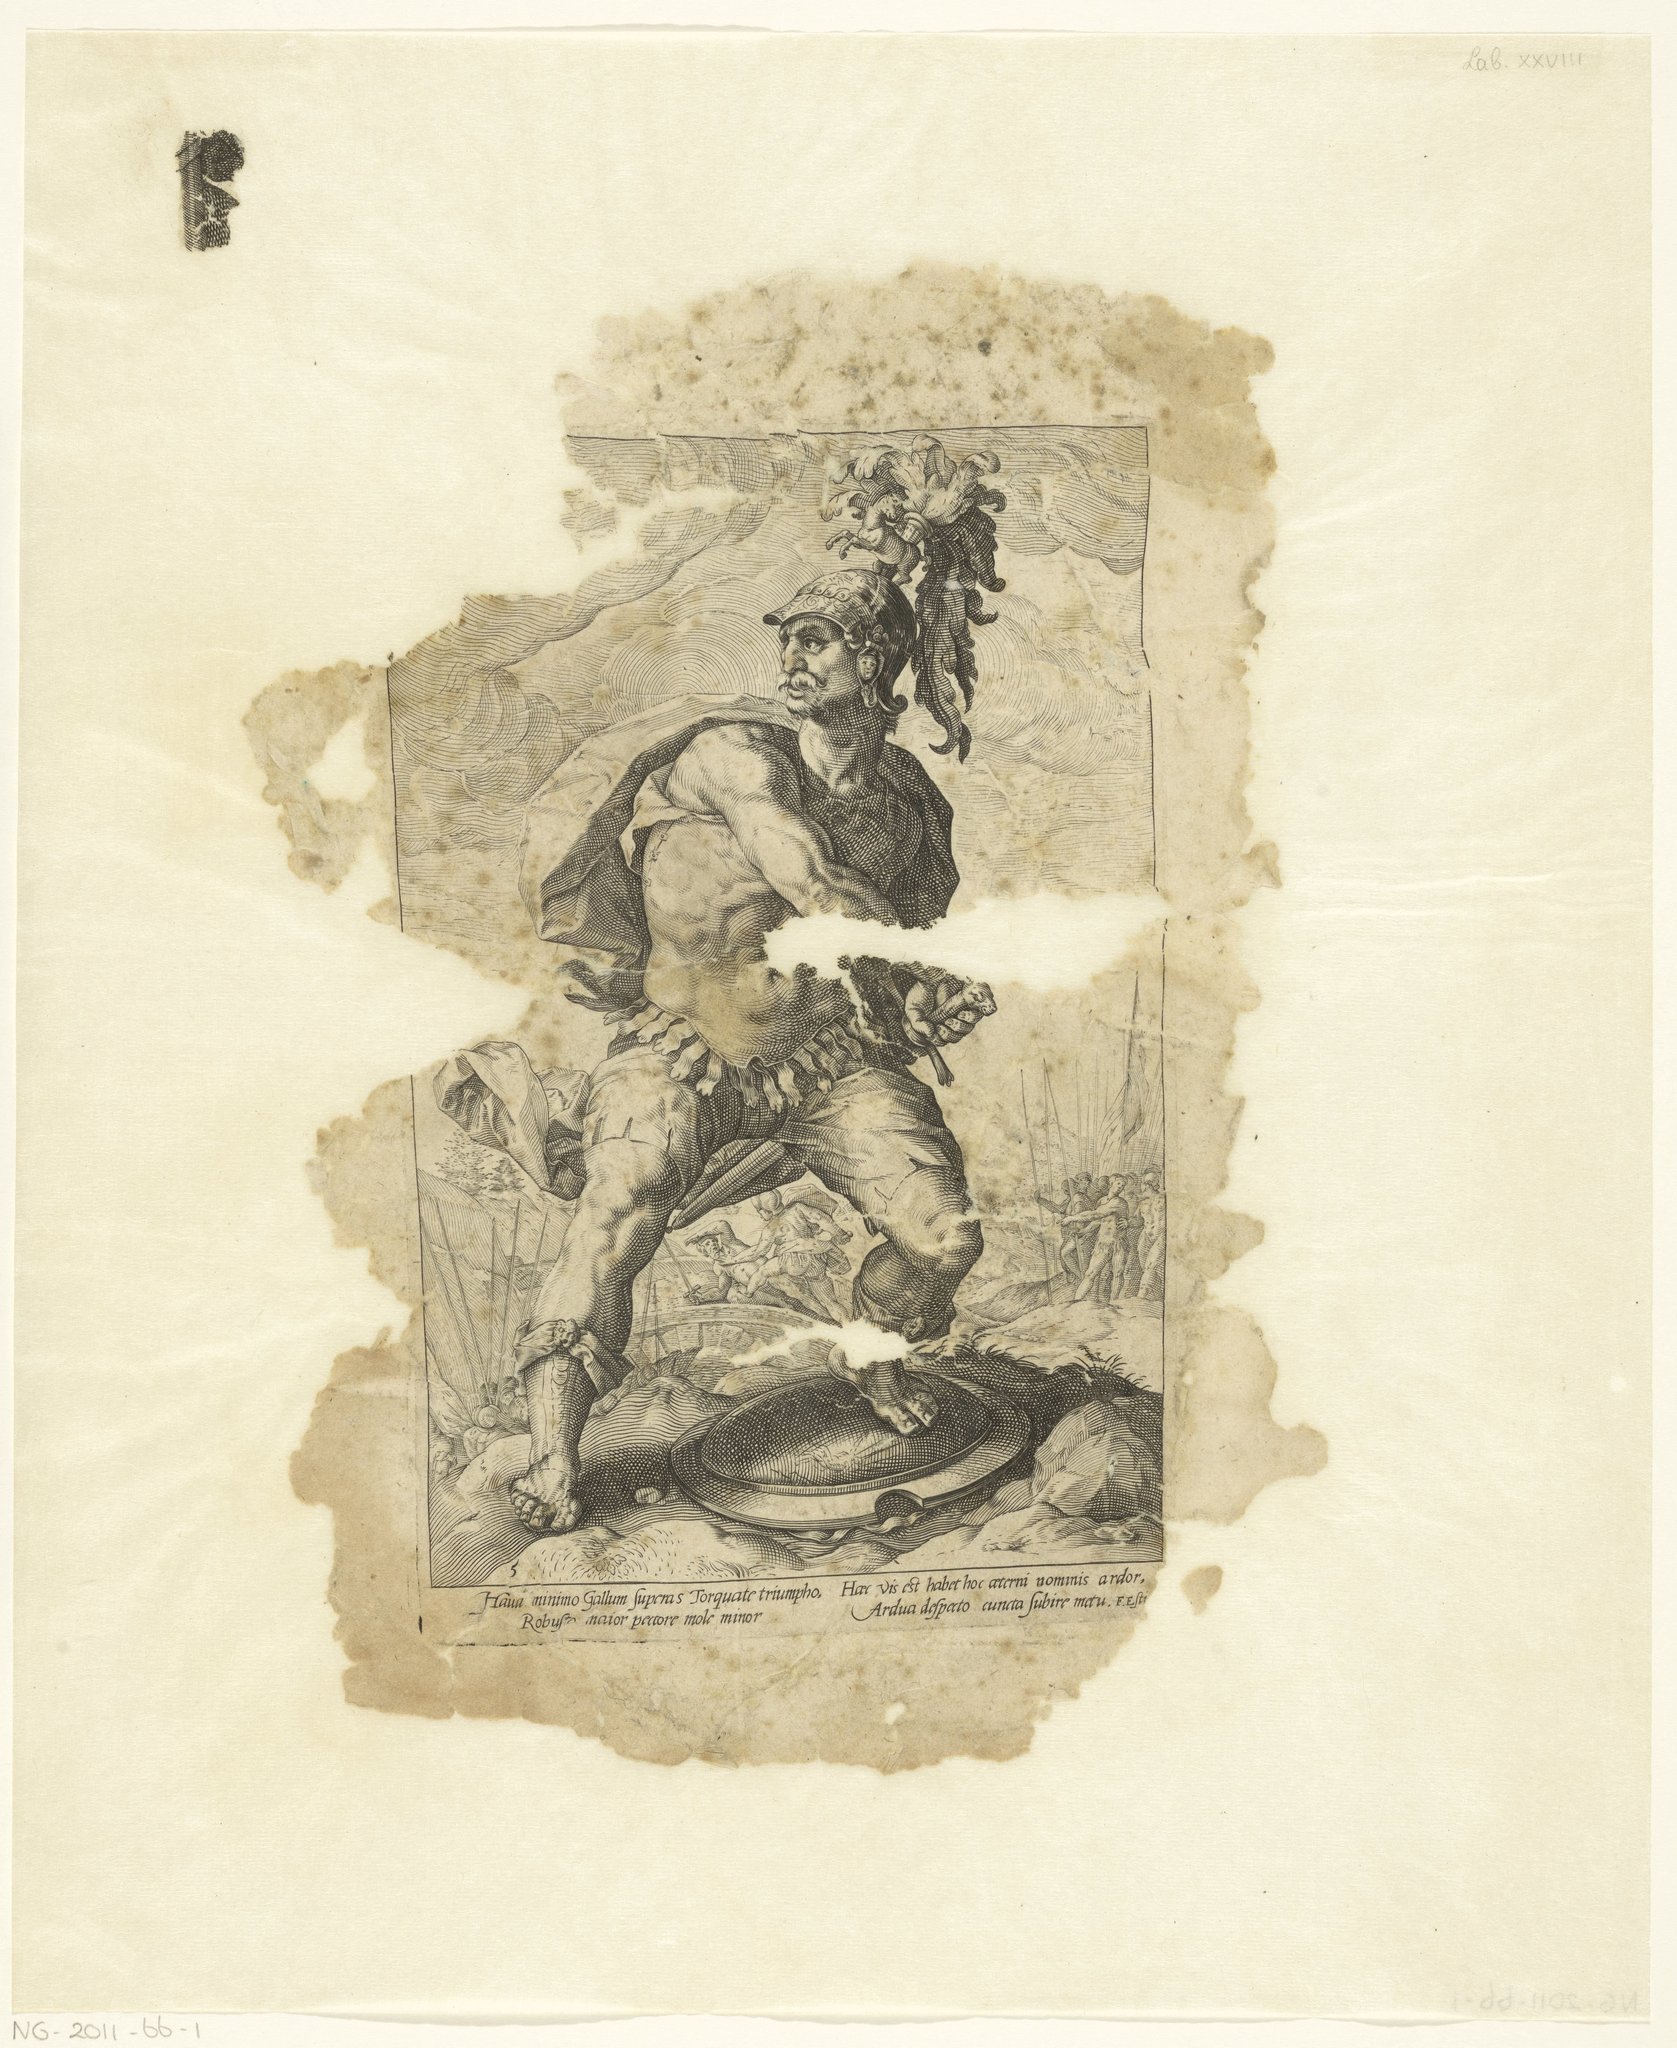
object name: print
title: Romeinse helden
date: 1586-1596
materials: paper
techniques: engraving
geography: northern netherlands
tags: titus manlius torquatus defeats in single combat a gigantic gaul and takes from him his golden neck-chain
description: Deze prent is onderdeel van een serie van tien prenten, bestaand uit een ongenummerde titelprent, acht genummerde voorstellingen van helden en een ongenummerde afsluitende prent. De prenten in de Nova Zembla collectie zijn tijdens een expeditie van Willem Barendsz en Jacob van Heemskerk in 1596-1597 noodgedwongen in het winterkamp, het ‘Behouden Huis’, op het eiland achtergelaten. De prenten waren in één of meerdere stapels als handelswaar meegenomen vanuit Amsterdam. Bijna drie eeuwen later, in 1871, keerde de Noor Elling Carlsen terug naar Nova Zembla en vond daar de restanten van het ‘Behouden Huis, inclusief een groot deel van de inventaris. Een deel van de prenten, in de vorm van aaneengekoekte kluiten, werd toen ook teruggevonden. De papierkluiten waren soms op meerdere plekken gebroken. Tussen 1975-1979 zijn de prenten van elkaar gescheiden. Dit leverde in totaal ca. 1000 fragmenten van ca. 400 afdrukken van ca. 150 verschillende prenten op. Voor zover mogelijk zijn de fragmenten samengevoegd en zijn de prenten gereconstrueerd.